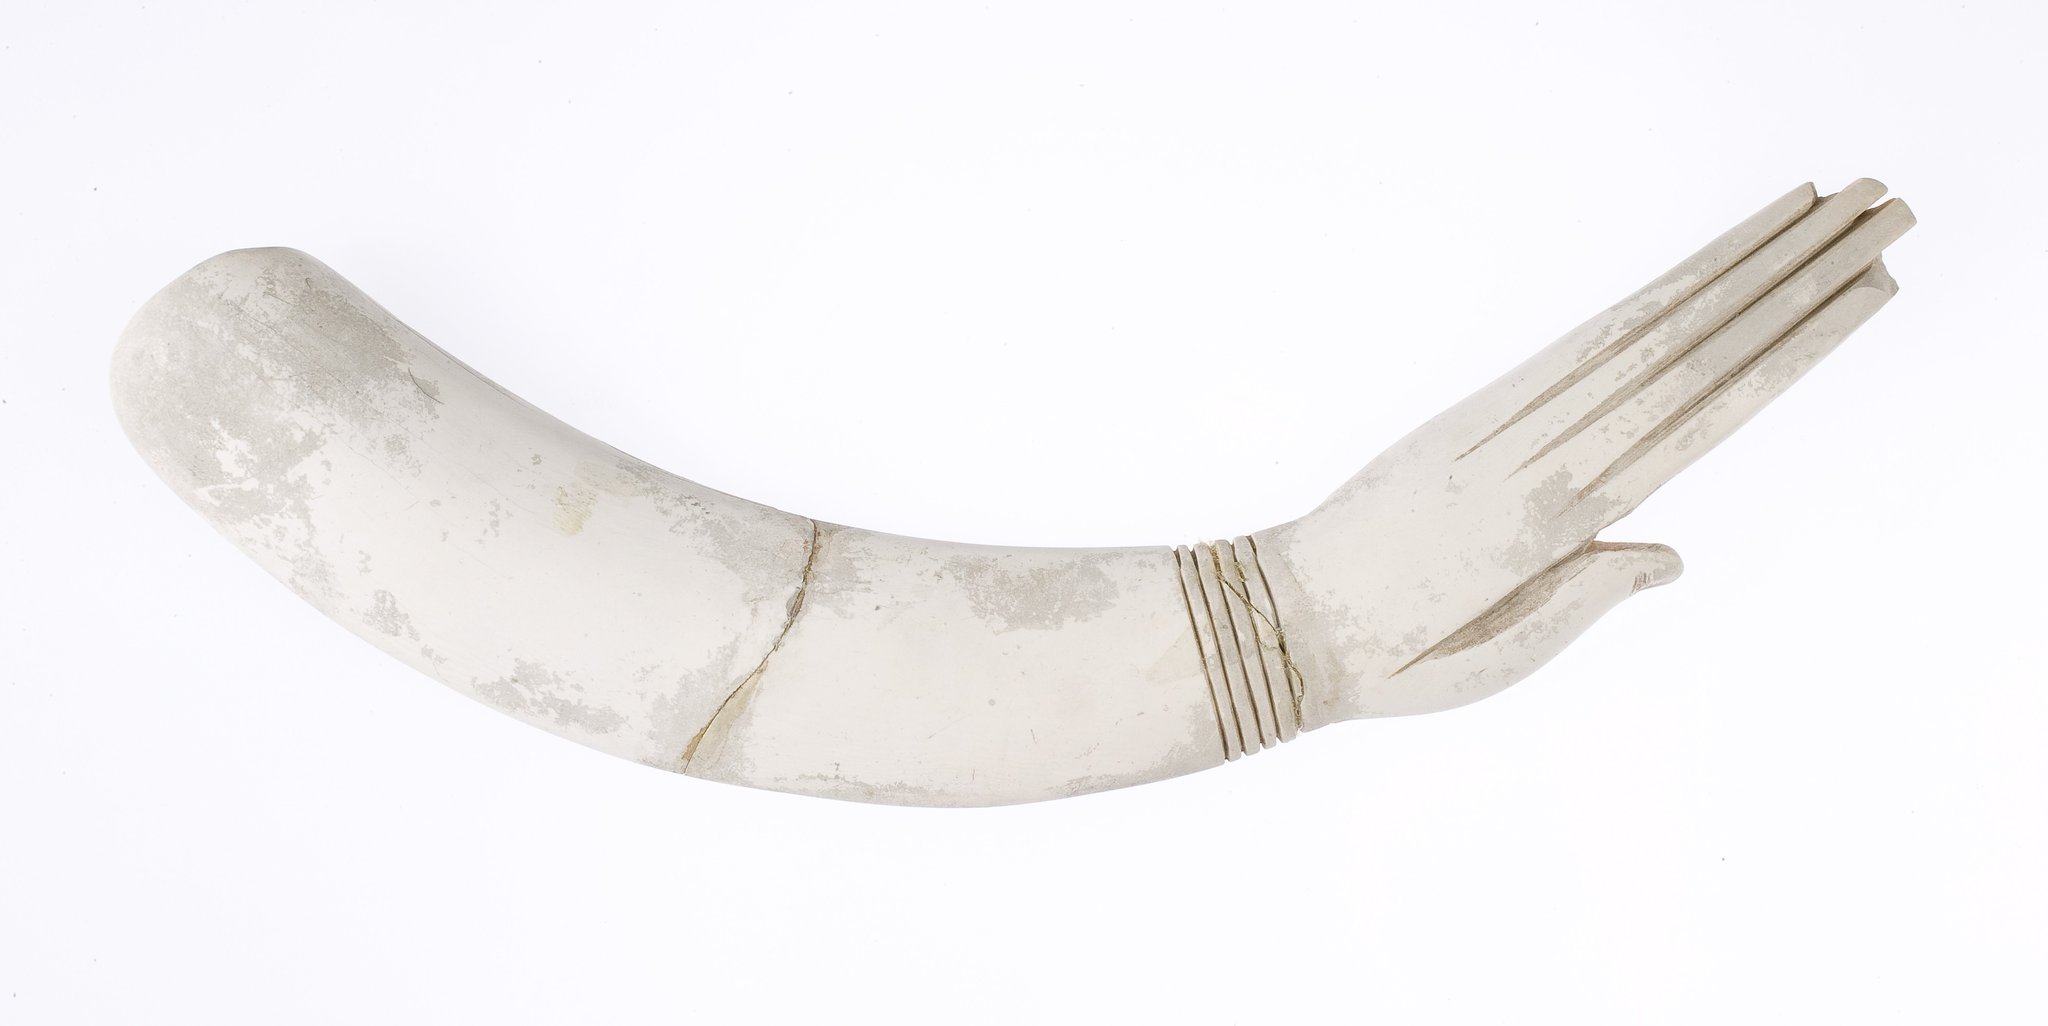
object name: music, clapper, arm, hand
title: Clapper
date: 1900-1800 BCE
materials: ivory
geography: egypt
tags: musical instruments